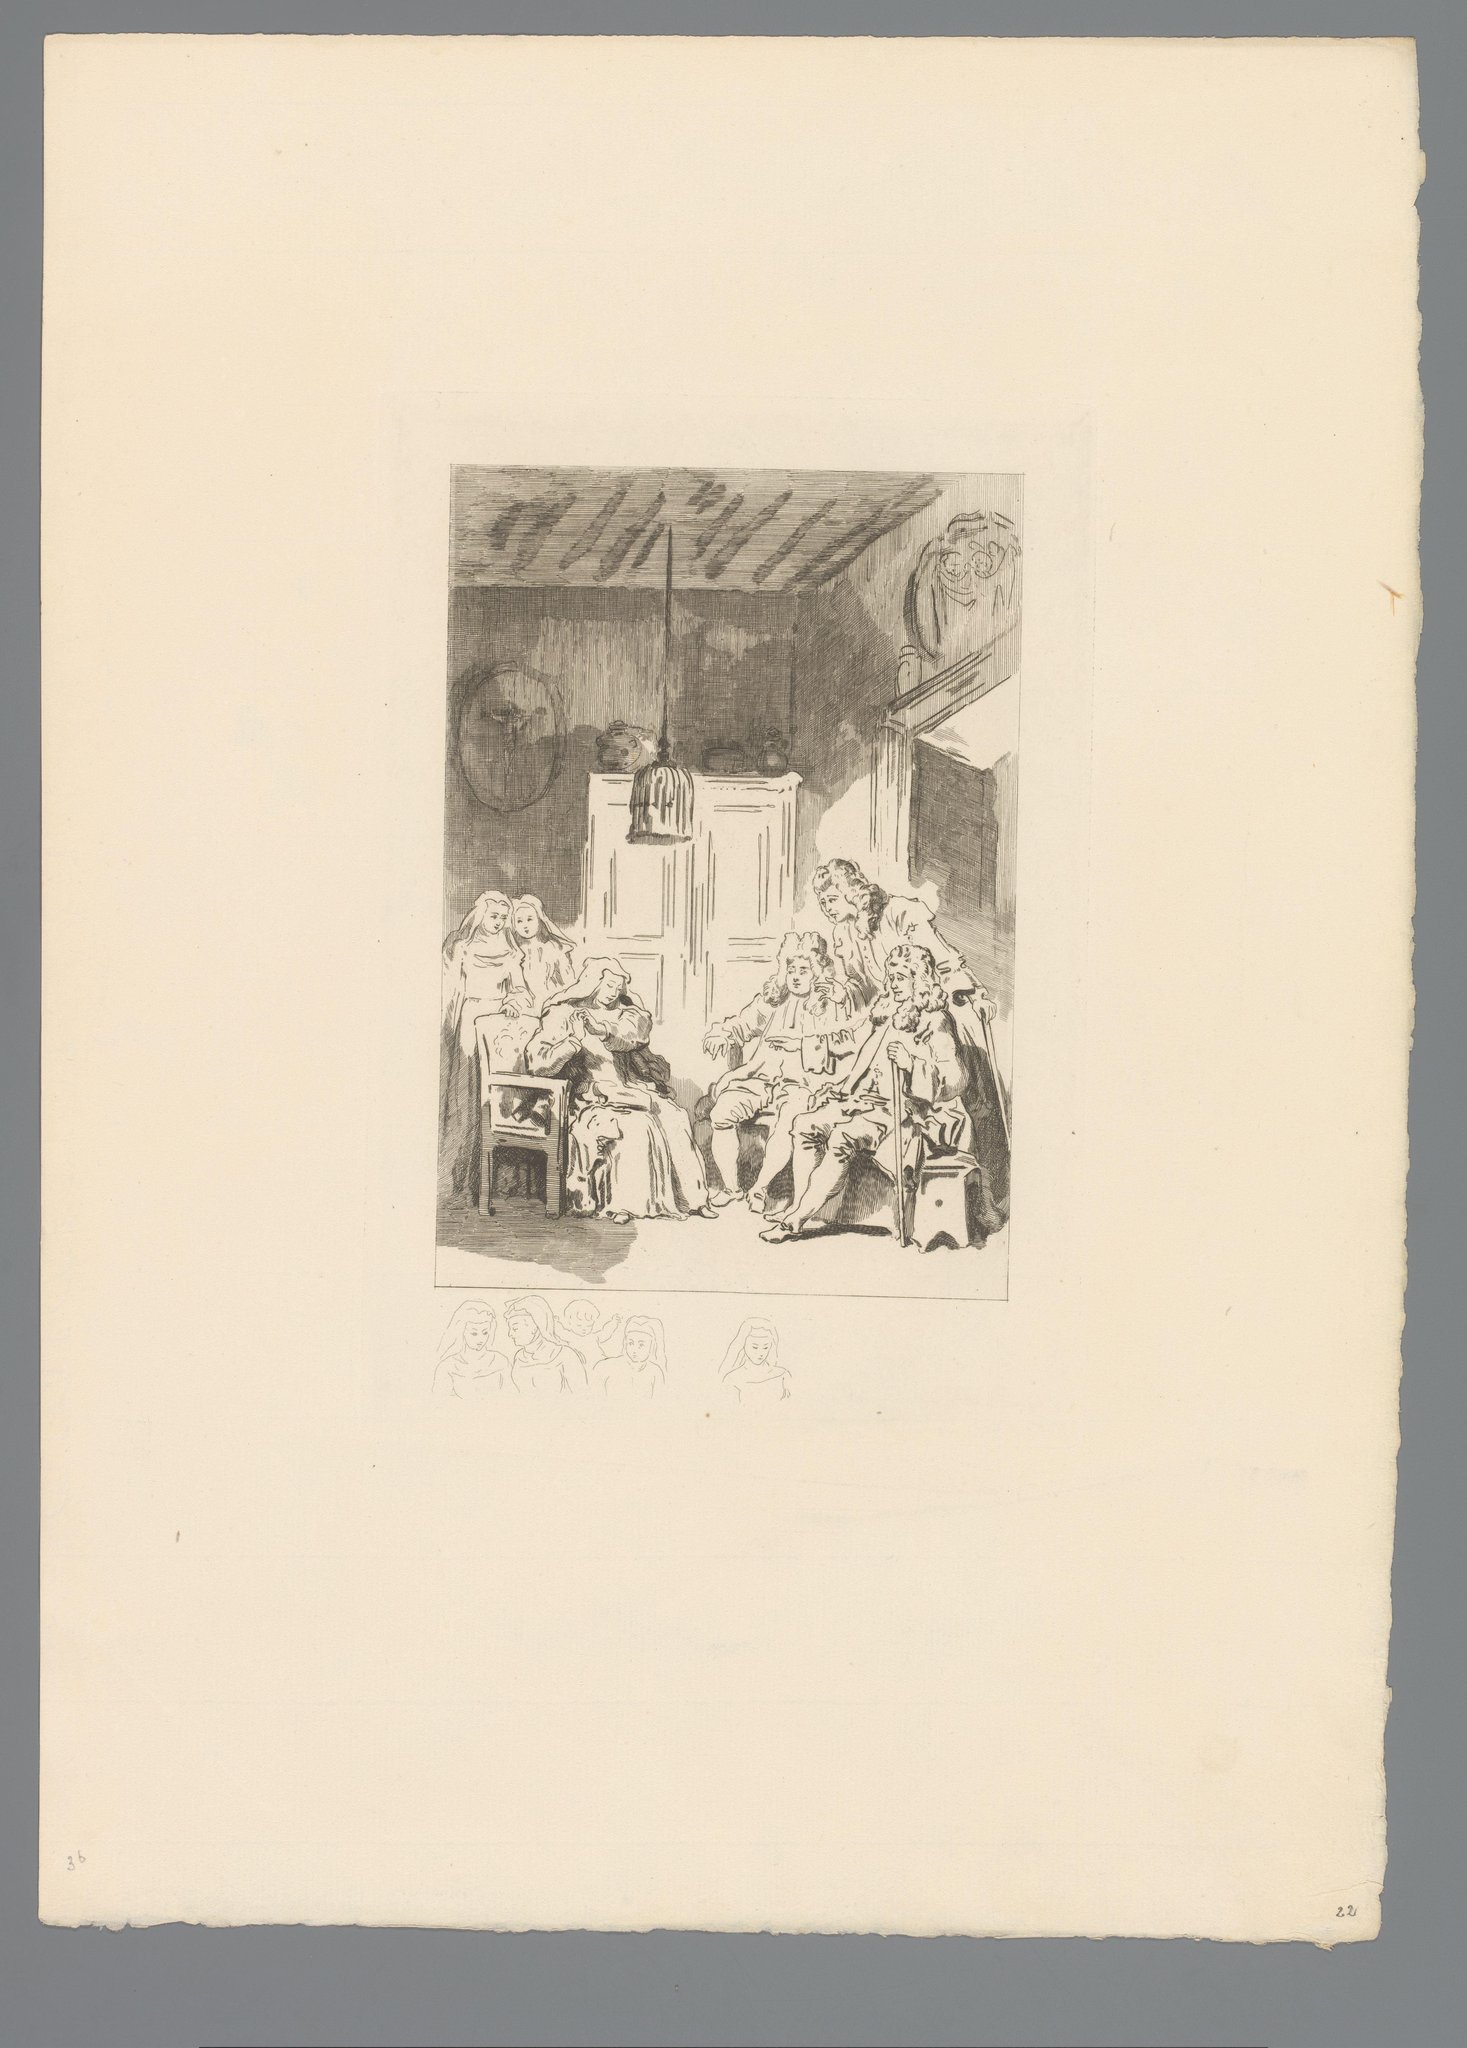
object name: reproduction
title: Reproductie van een prent naar een tekening van een gezelschap van drie nonnen en drie mannen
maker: Anonymous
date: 1880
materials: paper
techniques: photoaquatint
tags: nun(s), visiting the sick; sick person together with others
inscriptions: collector's mark: Lugt 2228, collector's mark:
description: Martial Potémont maakte etsen naar de tekeningen van Fragonard, die zich bevonden in een manuscript in de collectie van de verzamelaar Eugène Paillet. Rouquette bood hem aan de tekeningen zo exact mogelijk in prent te laten brengen door Martial Potémont: dit resulteerde in een serie van 57 etsen. Vervolgens werden deze gereproduceerd door middel van heliogravure. Deze omslag betreft een editie voor de letter, "Eau forte pure", de 1e staat van 3 waar men uit kon kiezen bij deze serie.